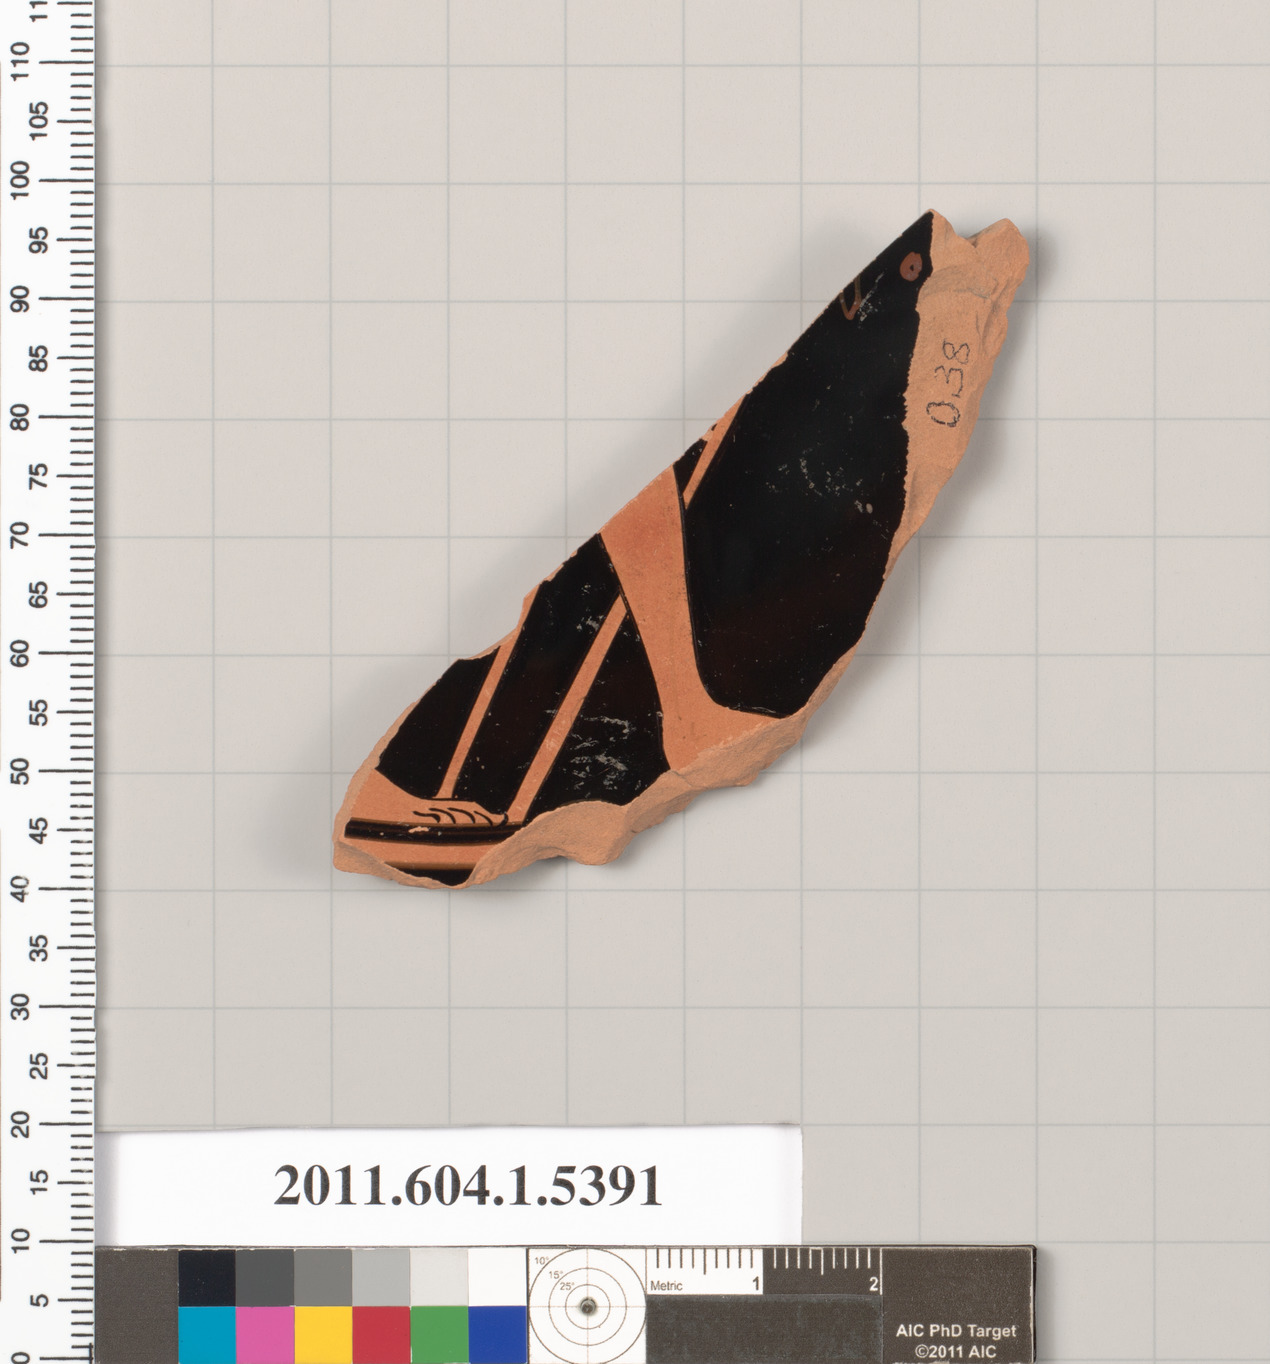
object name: kylix fragment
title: Terracotta fragment of a kylix (drinking cup)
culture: greek, attic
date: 500-480 BCE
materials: terracotta